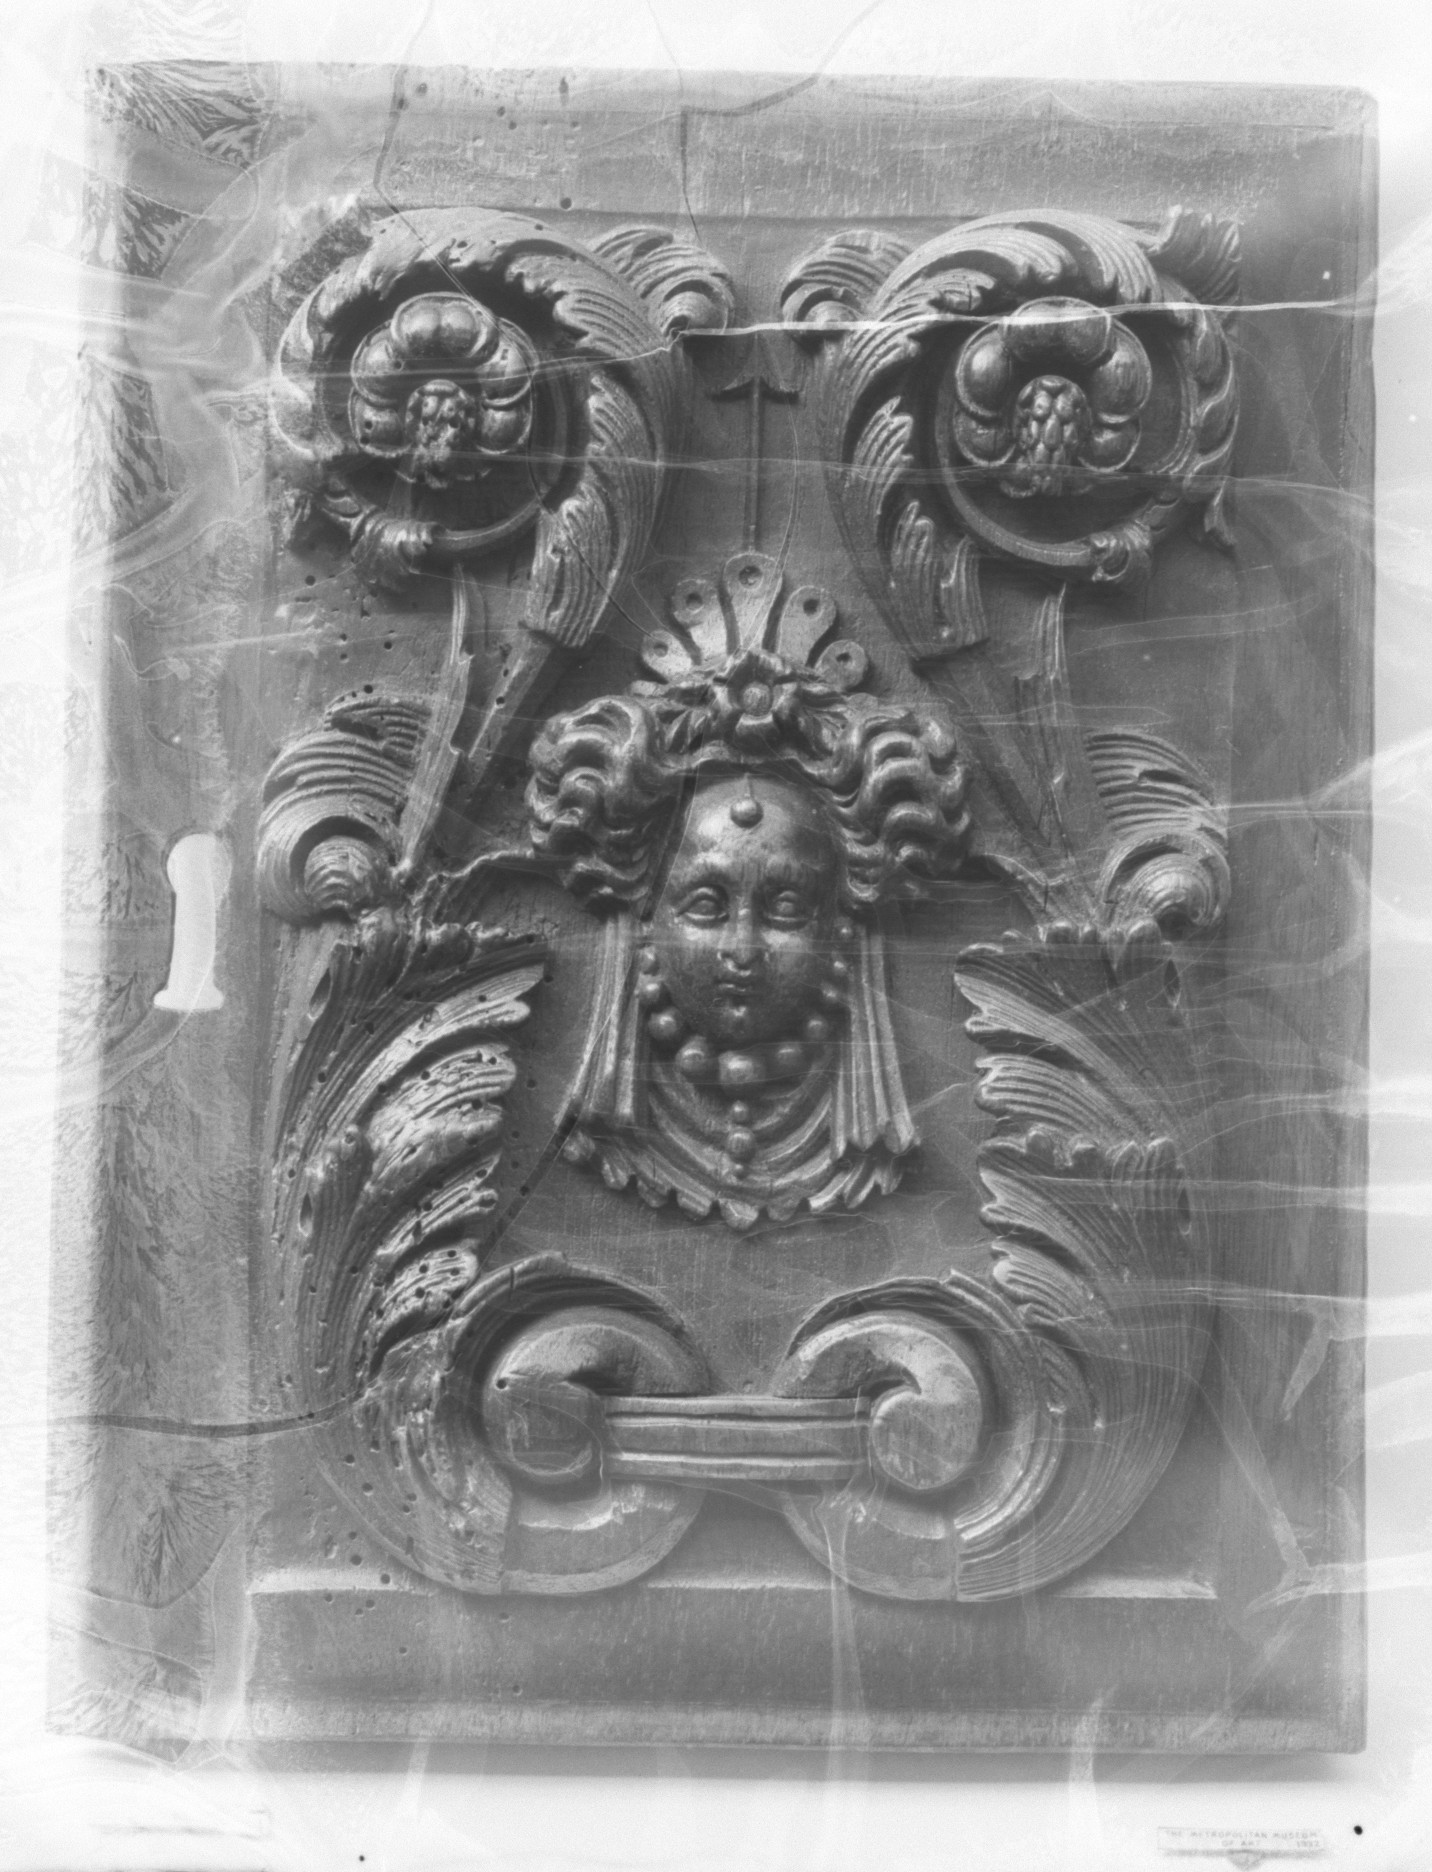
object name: panel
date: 1501-1600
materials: wood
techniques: carving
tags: faces